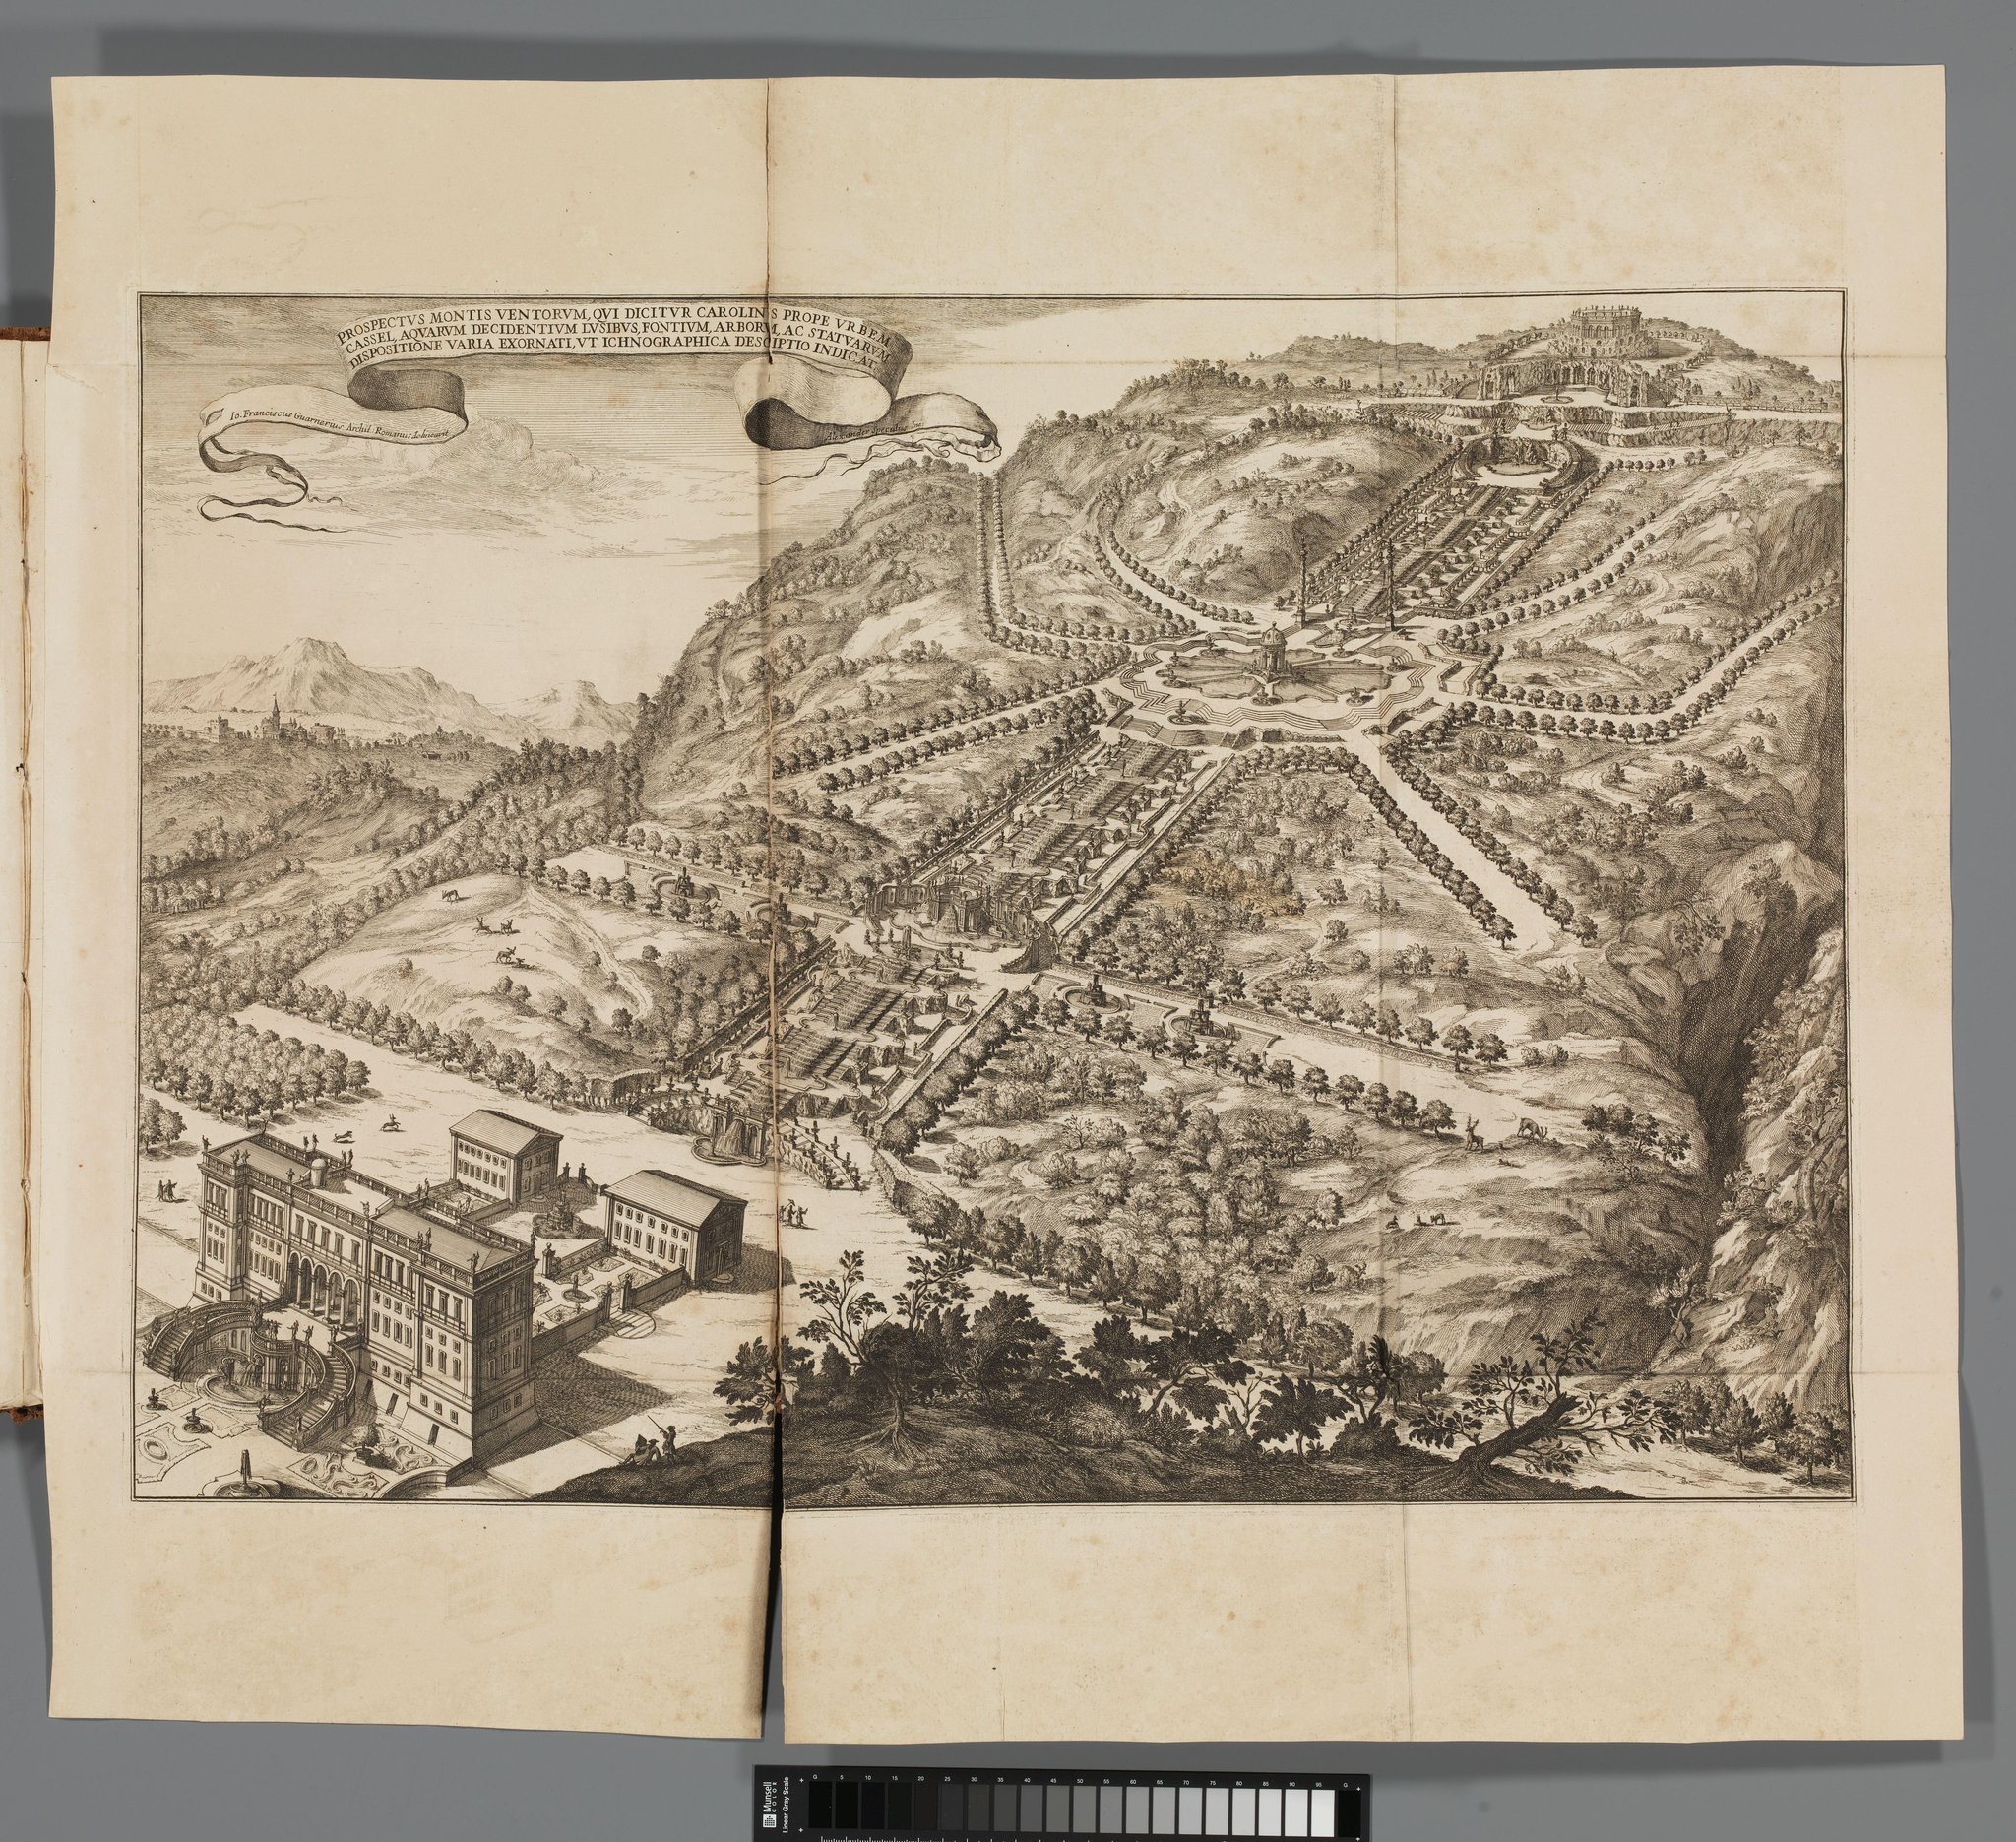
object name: album leaf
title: Prosperctus montis ventorum, qui dicitur Carolinin prope urbem (...)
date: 1706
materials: paper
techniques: etching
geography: italy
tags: city-view, and landscape with man-made constructions, garden, garden fountain, palace, artificial grotto in garden